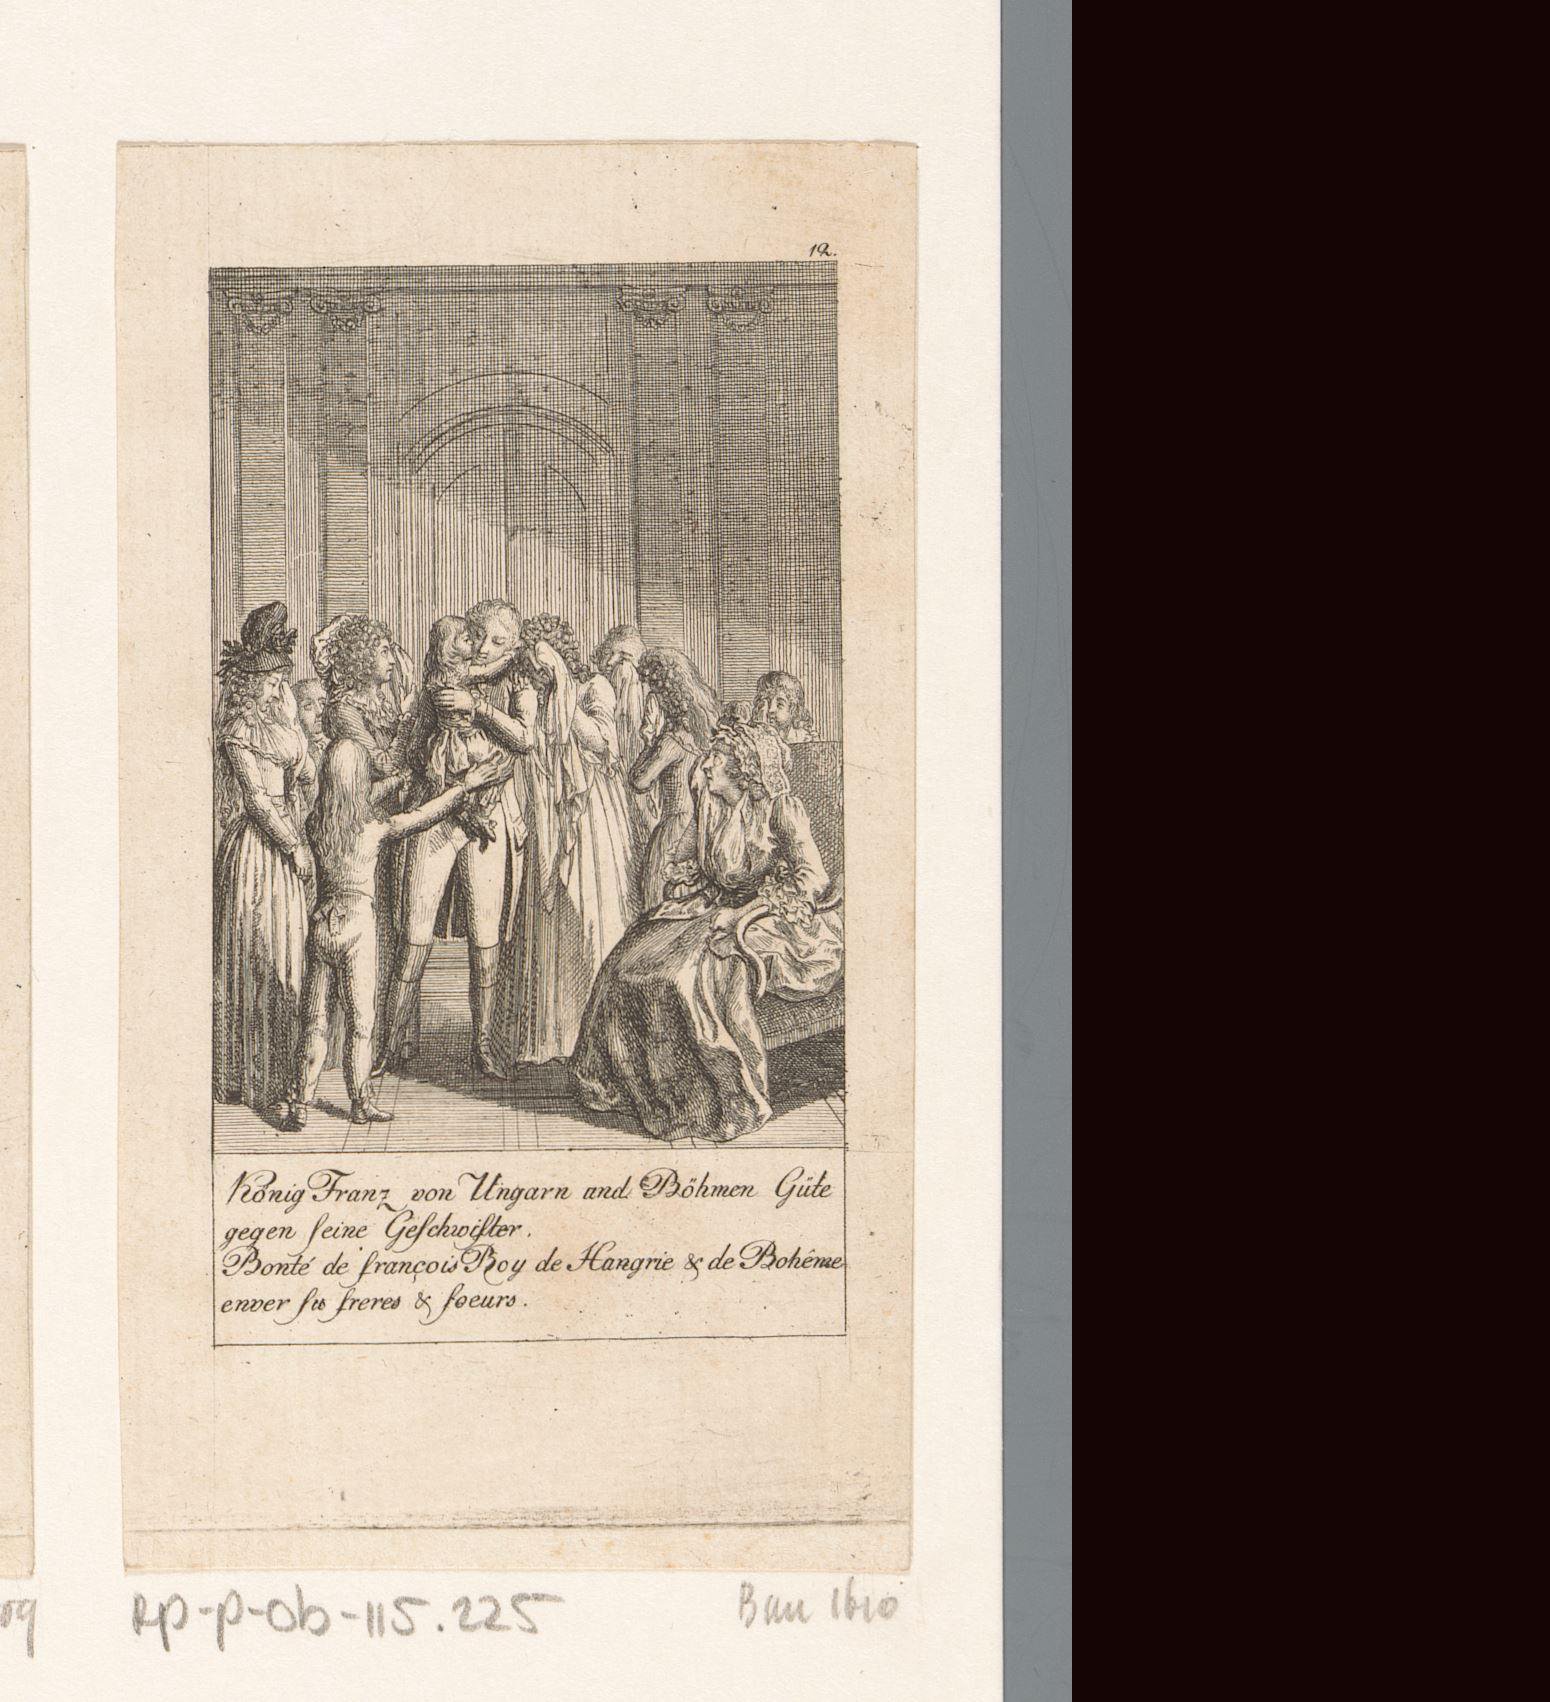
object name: print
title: Franz II troost zijn gezin na de dood van zijn vader, Leopold II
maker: daniel nikolaus chodowiecki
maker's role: draughtsman, print maker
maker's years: 1726-1801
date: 1792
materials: paper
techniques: etching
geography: berlin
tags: vienna, frans ii (rooms-duits keizer), consolation, history, emperor, family, descendance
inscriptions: collector's mark: Lugt 2228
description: Latere staat gebruikt voor: Almanac de Gotha pour l'anneé 1793. Gotha: C. W. Ettinger, [1792].